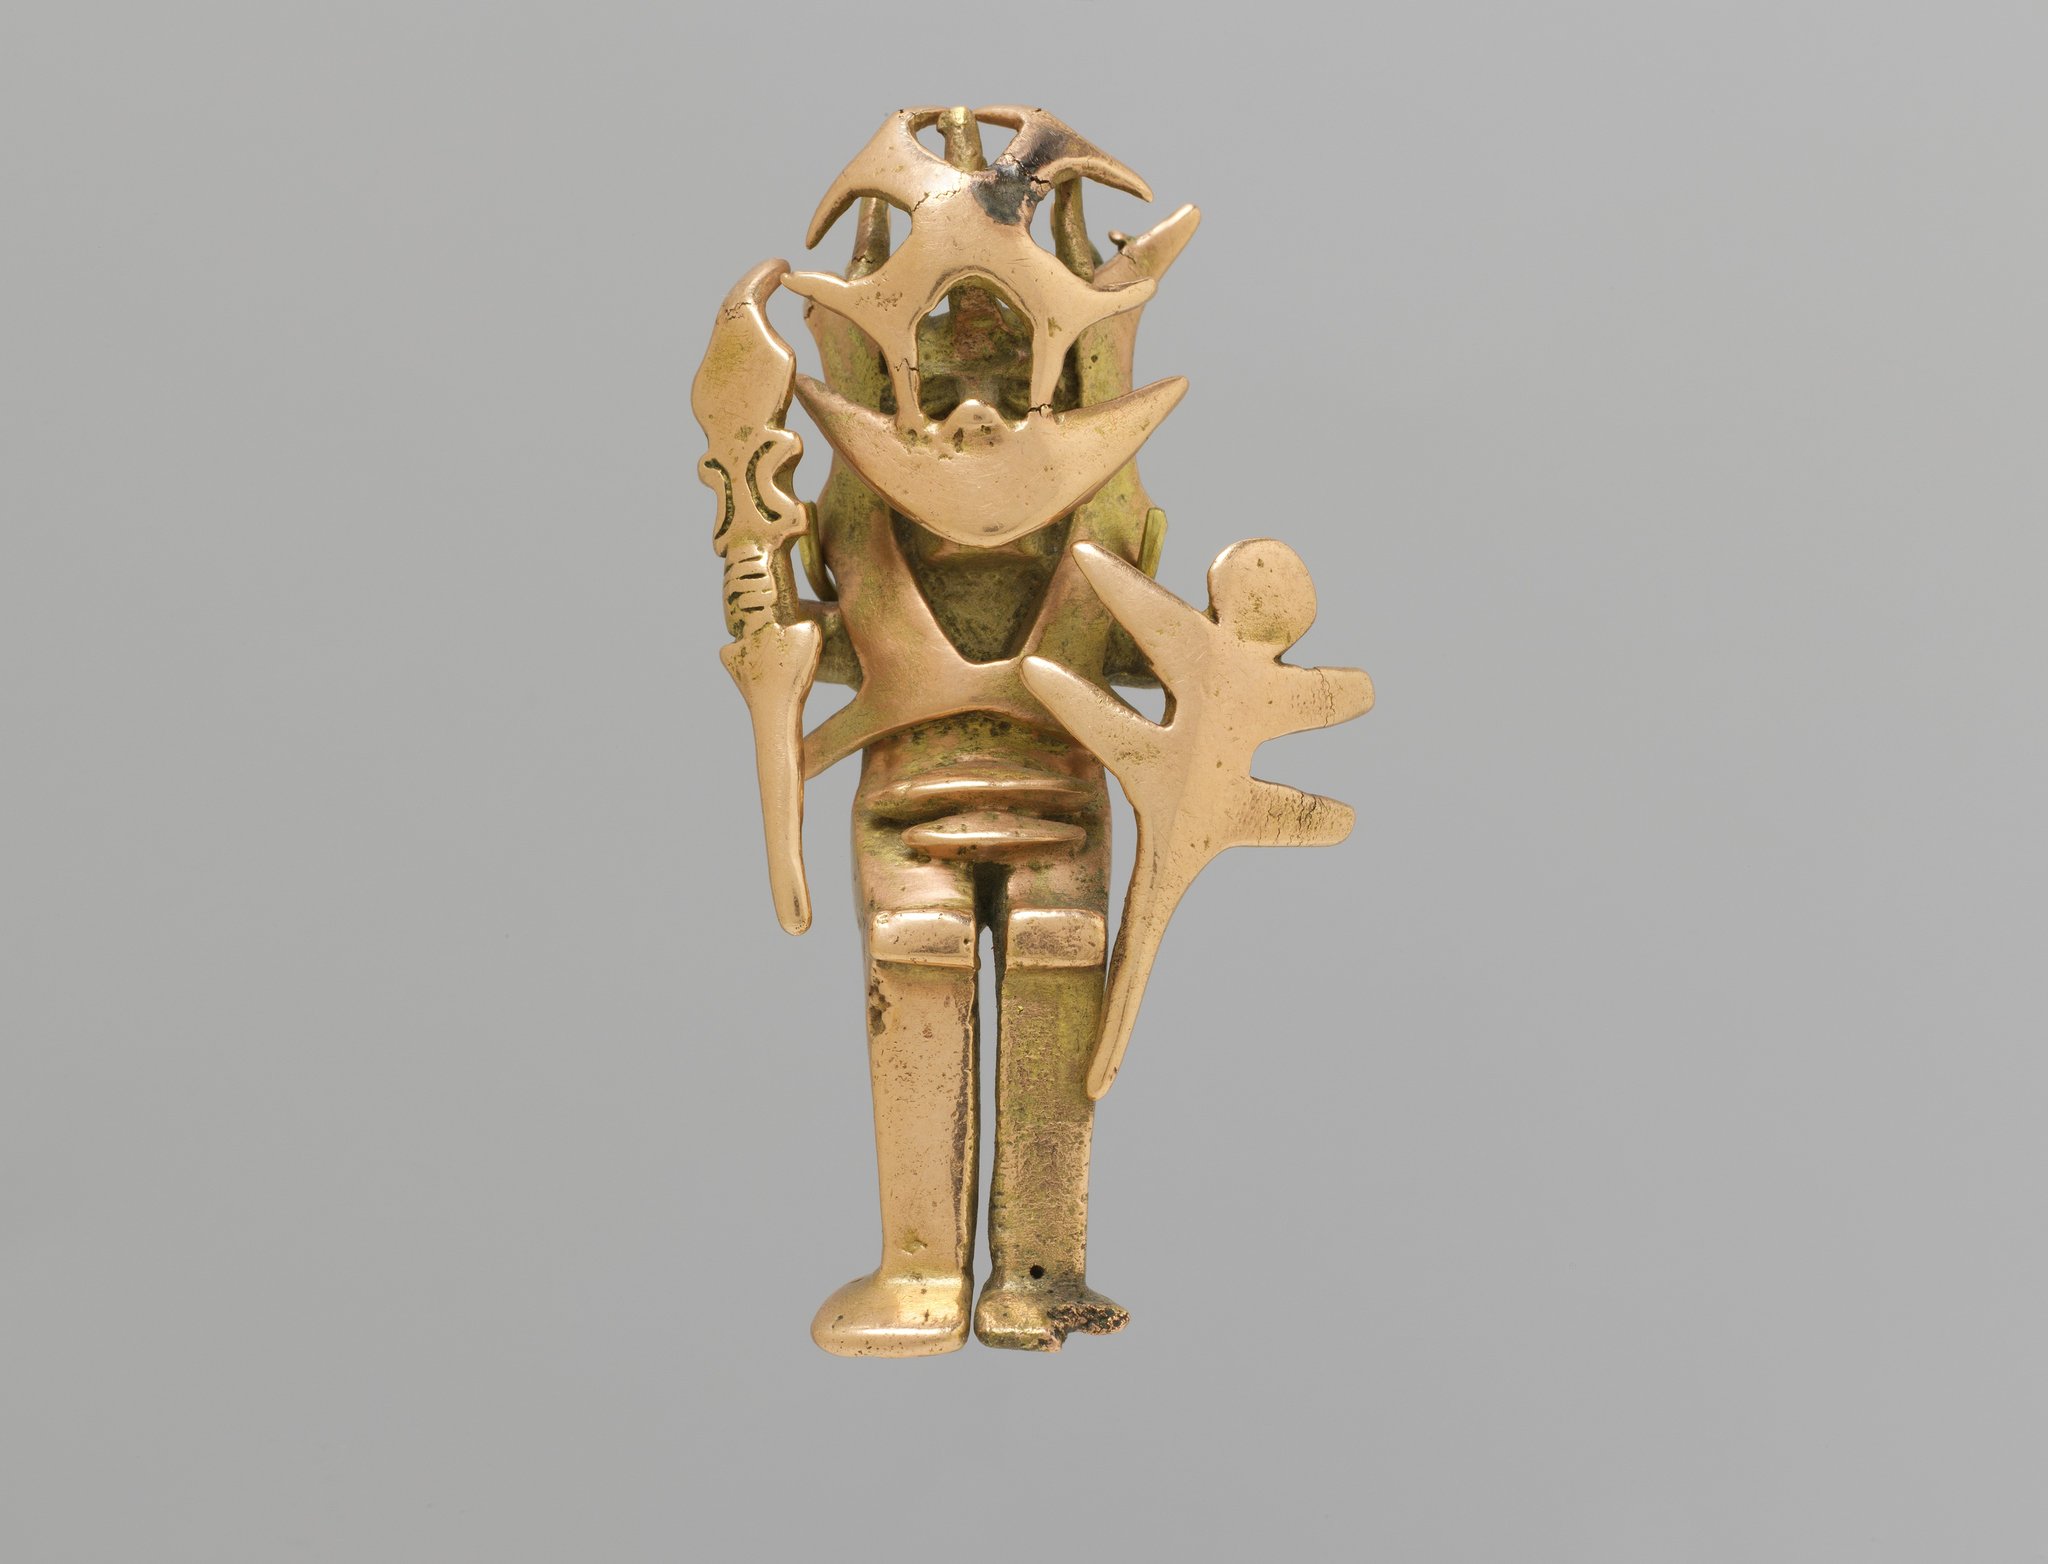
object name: pendant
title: Masked Figure Pendant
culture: calima or yotoco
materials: gold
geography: colombia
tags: human figures,masks